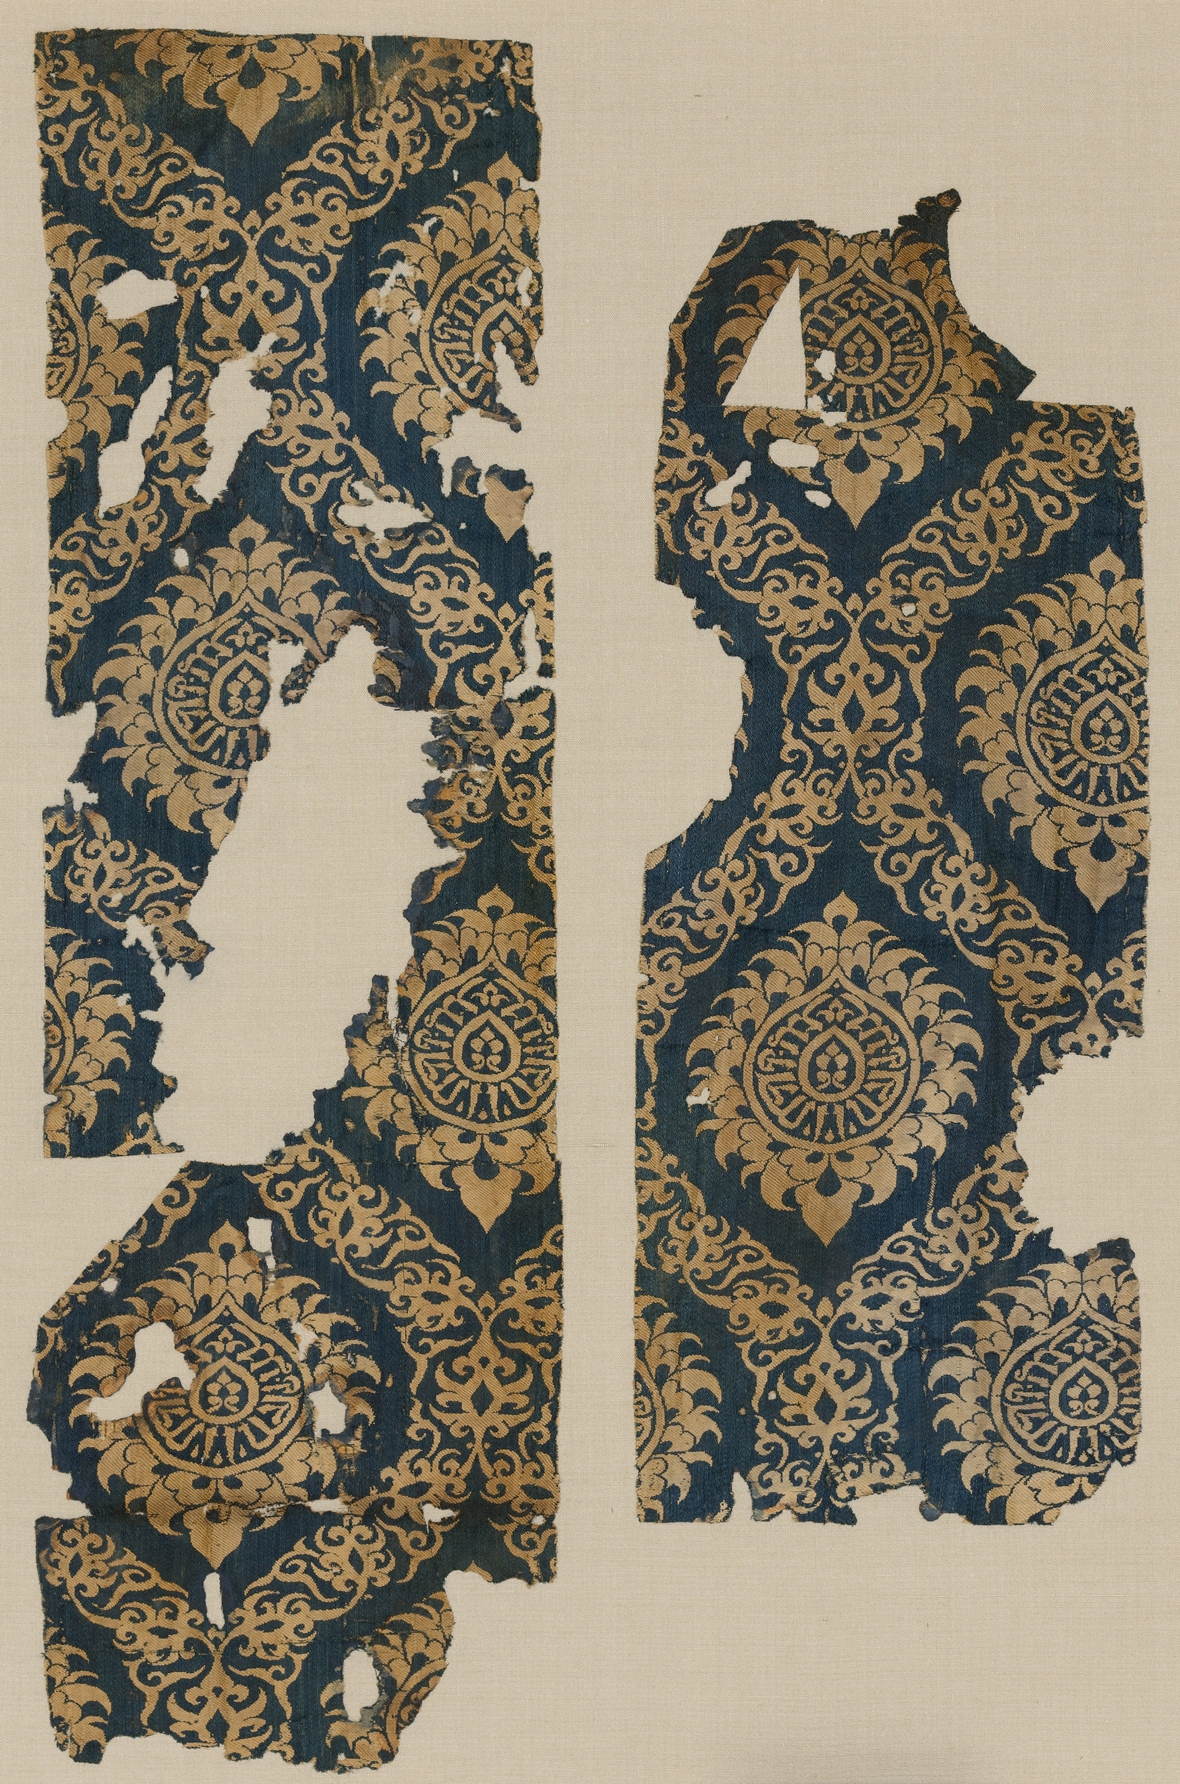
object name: textile fragment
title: Textile Fragment with Ogival Pattern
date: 1301-1400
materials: silk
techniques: lampas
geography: egypt or syria